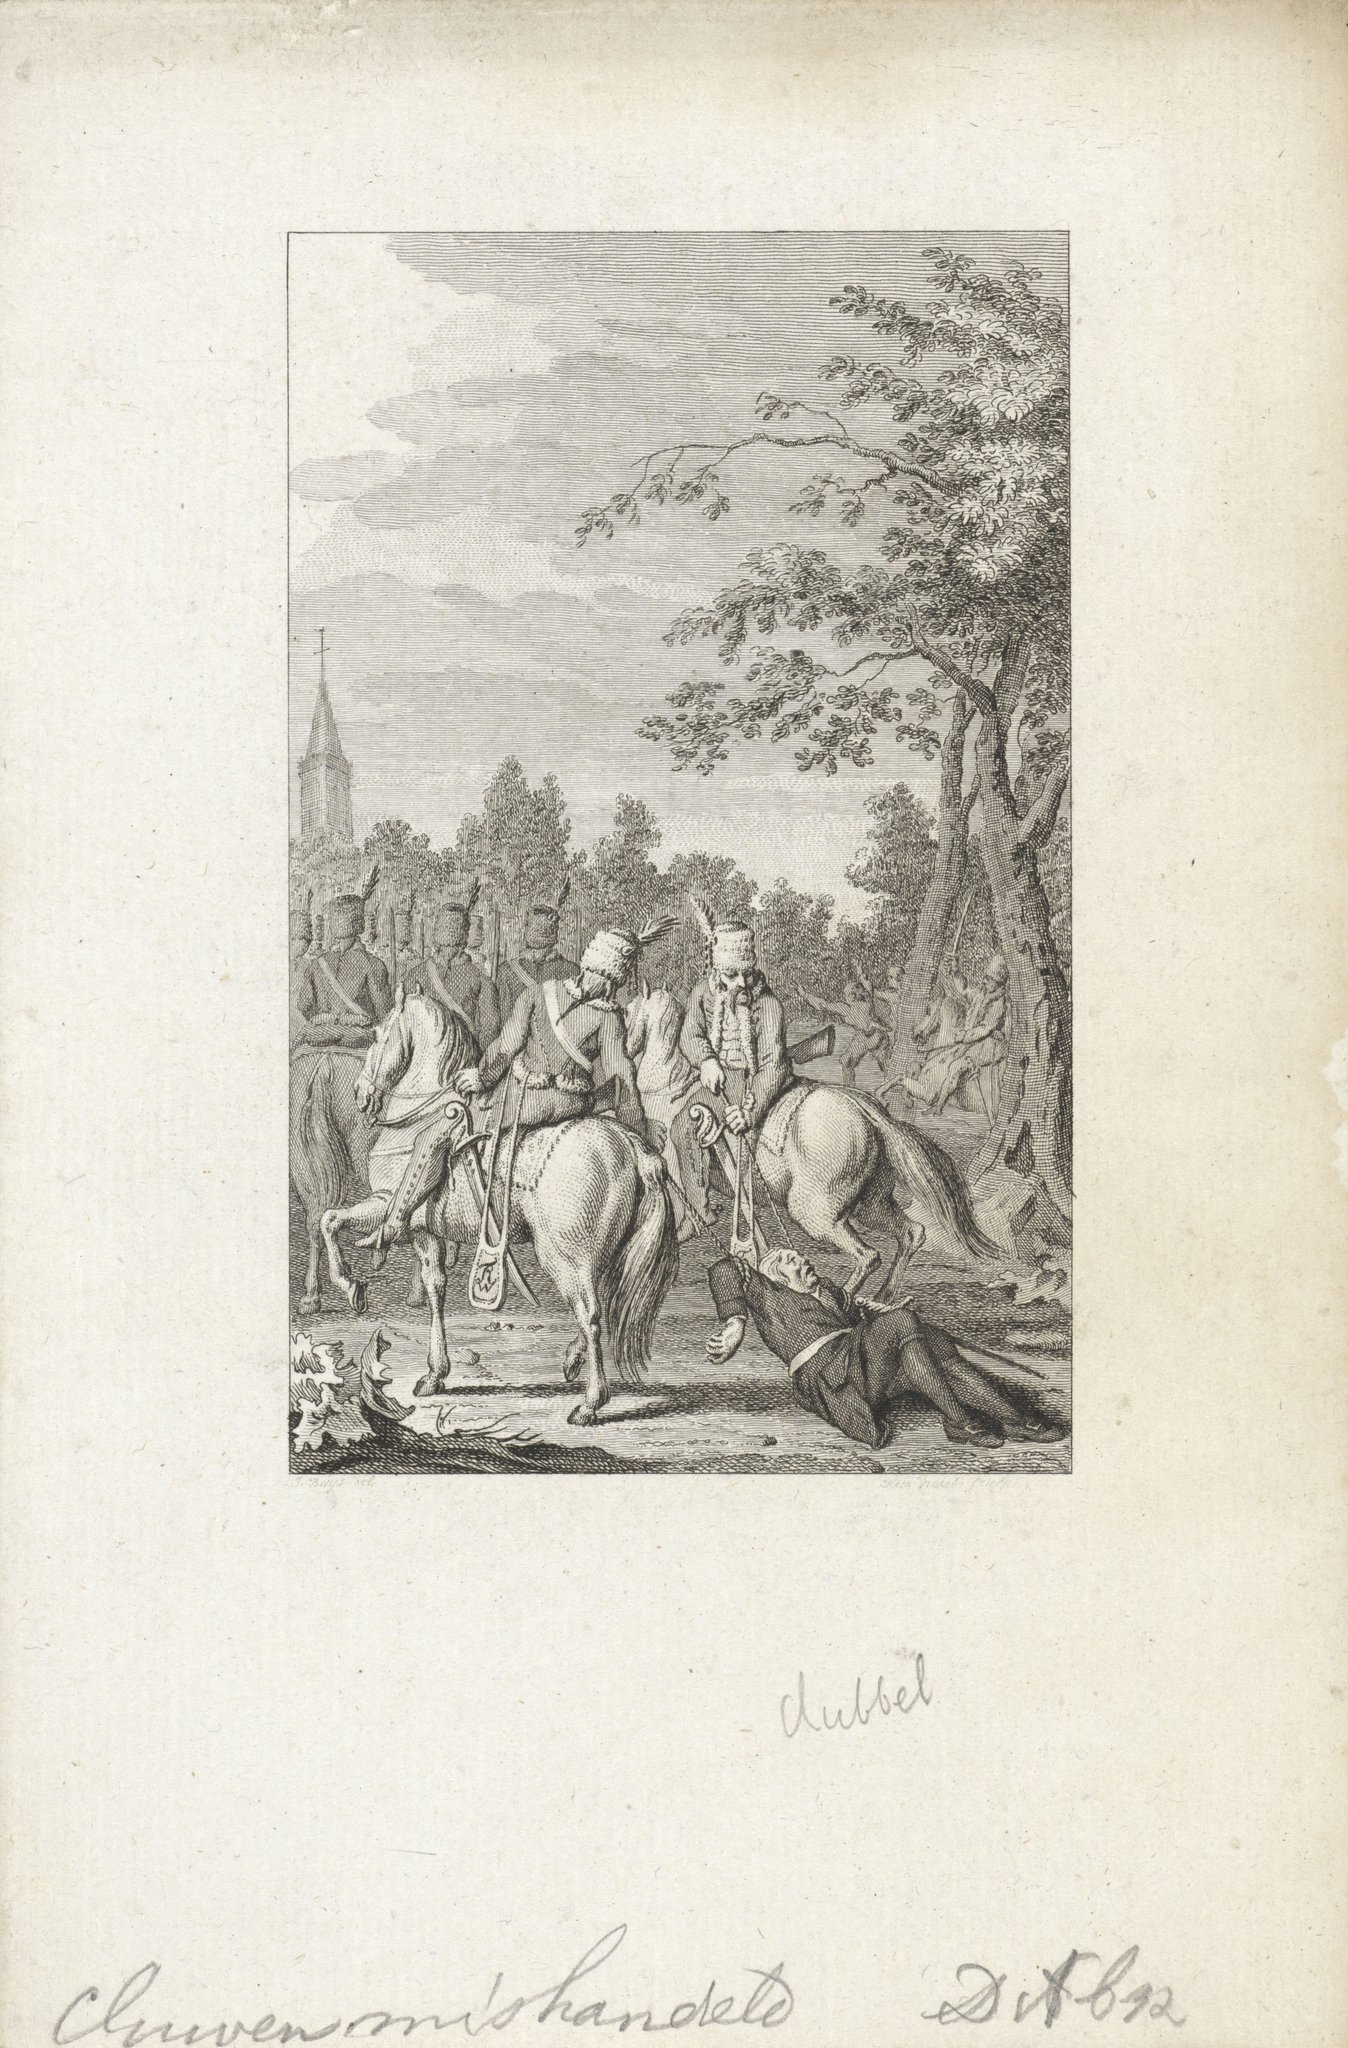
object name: print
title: Mishandeling van dominee Cluwen te Sluipwijk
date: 1796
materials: paper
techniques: engraving, etching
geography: amsterdam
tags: soldiers and civilians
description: Gebruikt als illustratie in: P.A. Loosjes. Vaderlandsche historie, vervattende de geschiedenissen, der Vereenigde Nederlanden (...). Ten onmiddelyken vervolge van Wagenaar's Vaderlandsche historie. Amsterdam: Johannes Allart, dl. 17.